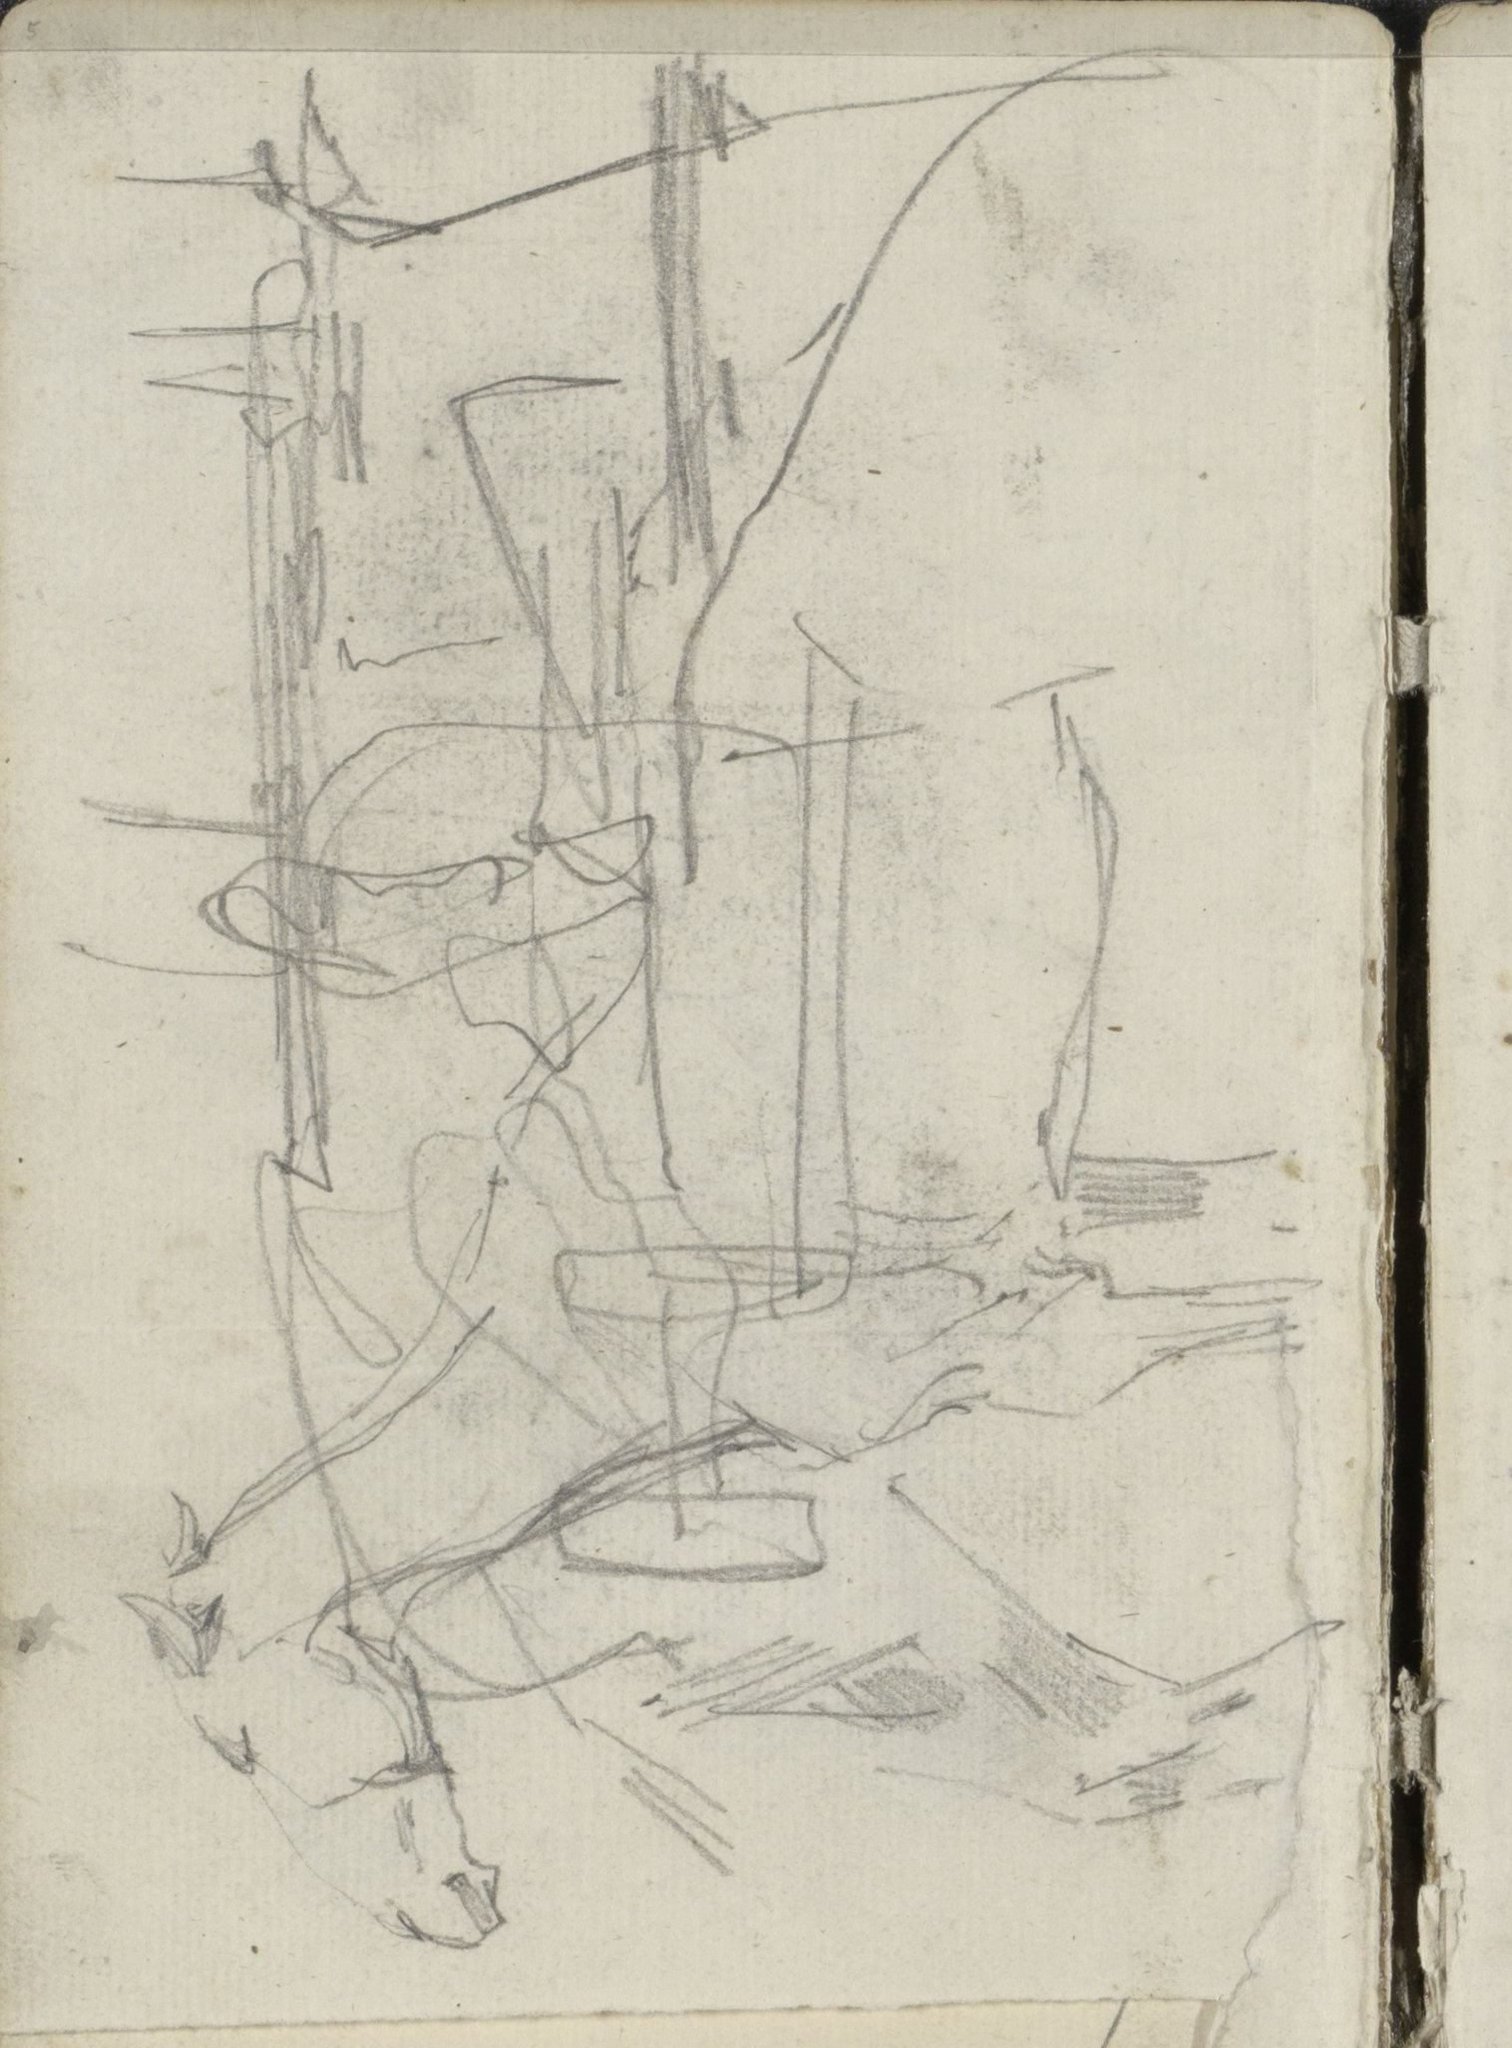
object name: sketchbook leaf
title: Paarden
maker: george hendrik breitner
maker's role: draughtsman, painter, print maker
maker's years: 1857-1923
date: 1881-1883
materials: paper, pencil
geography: the hague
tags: horse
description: Pagina 5 uit een schetsboek met 27 bladen.